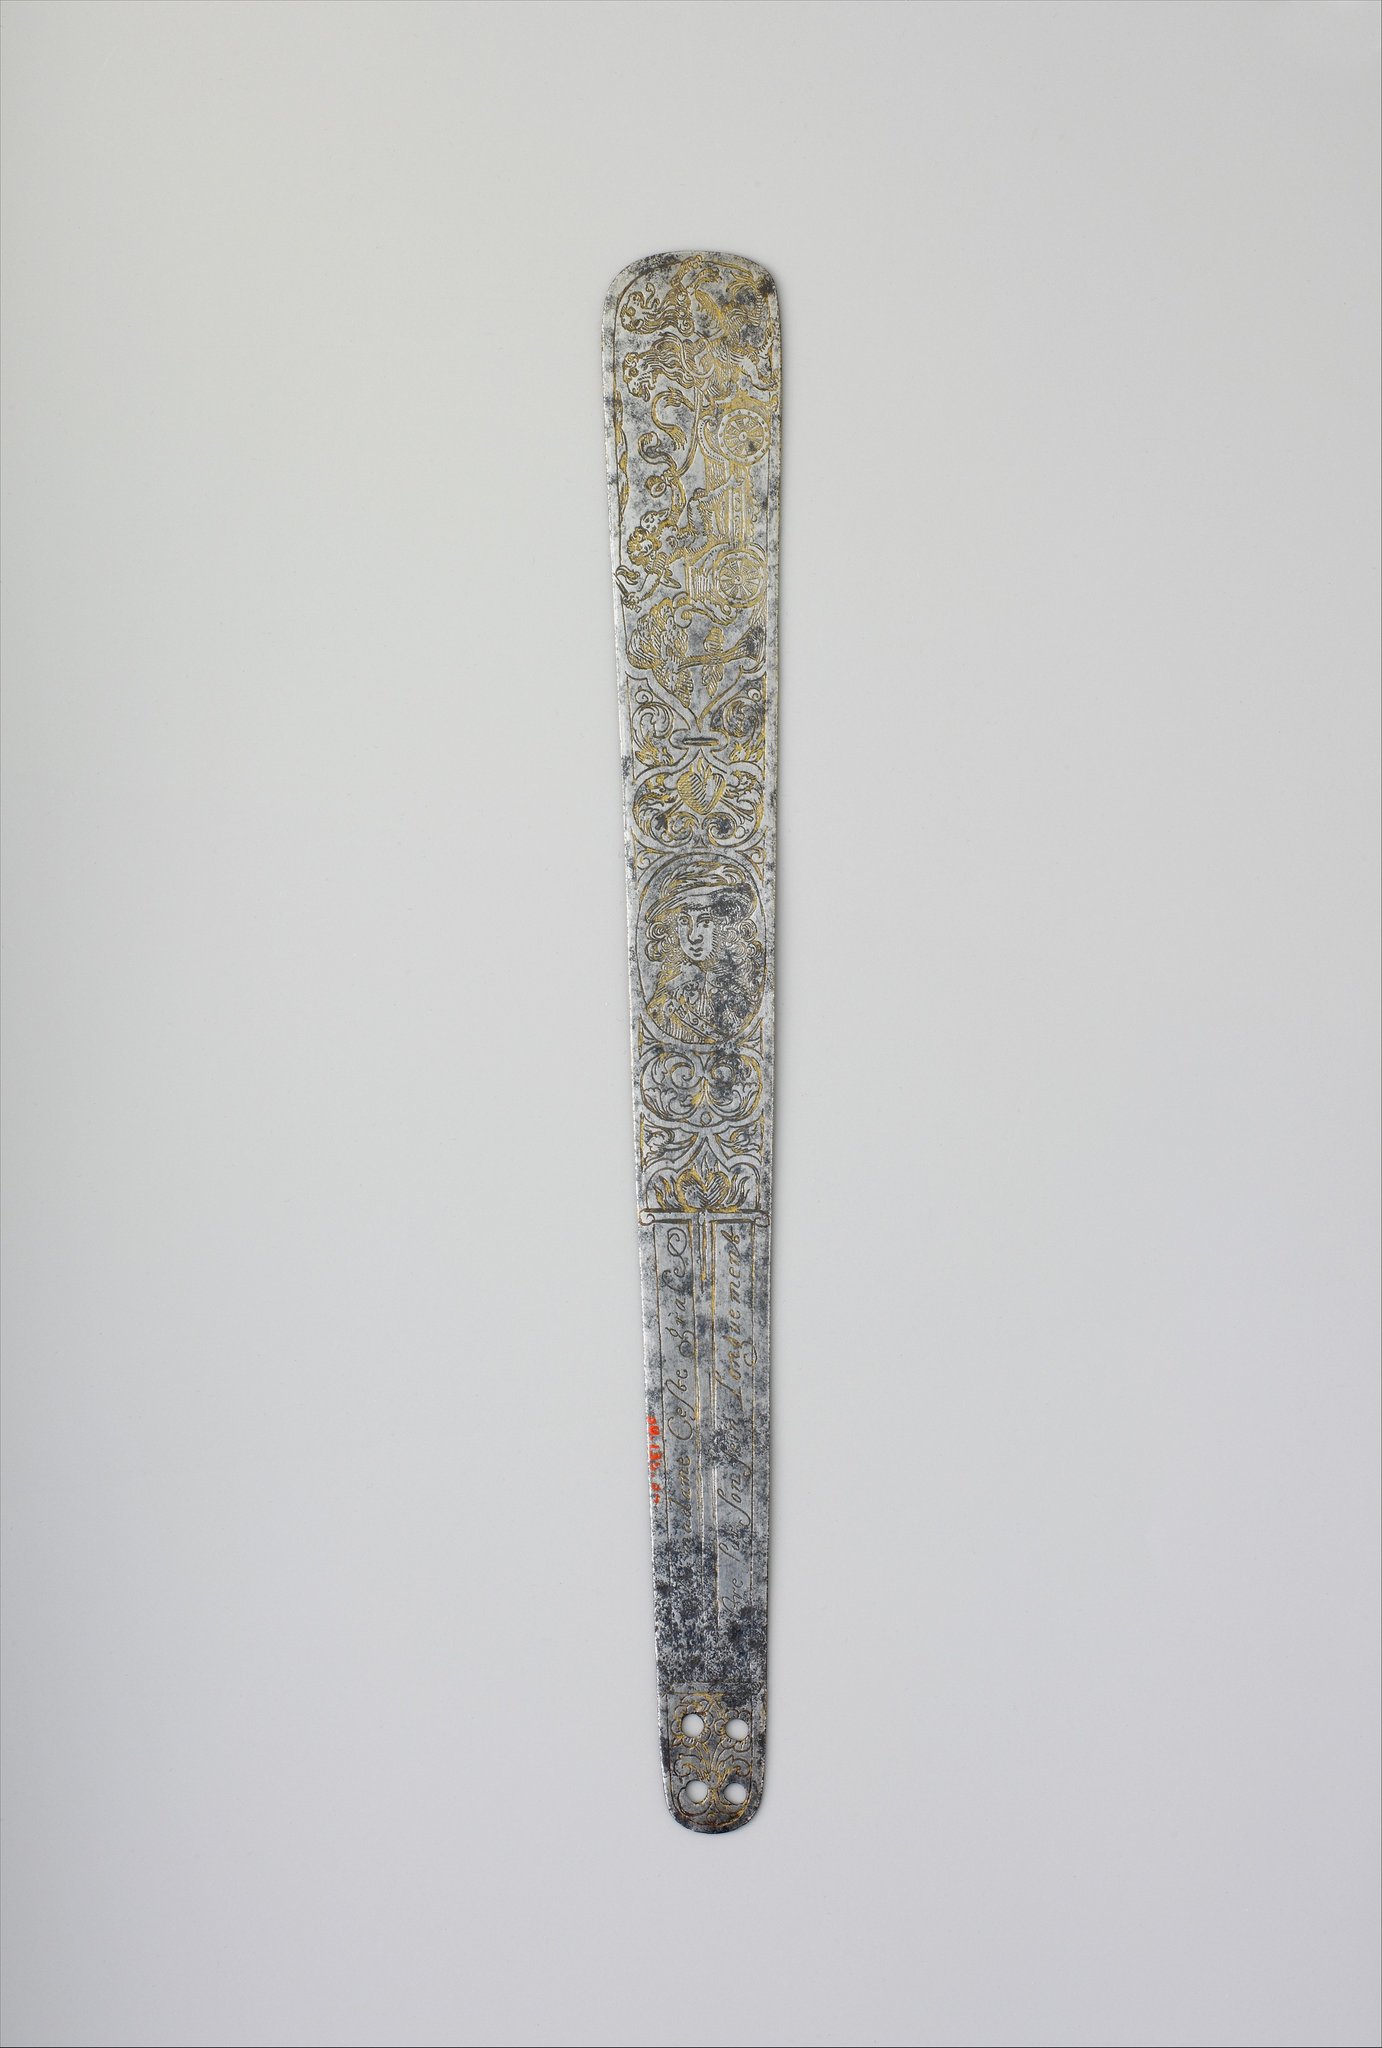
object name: busk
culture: french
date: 1601-1700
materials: metal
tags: men,cupid